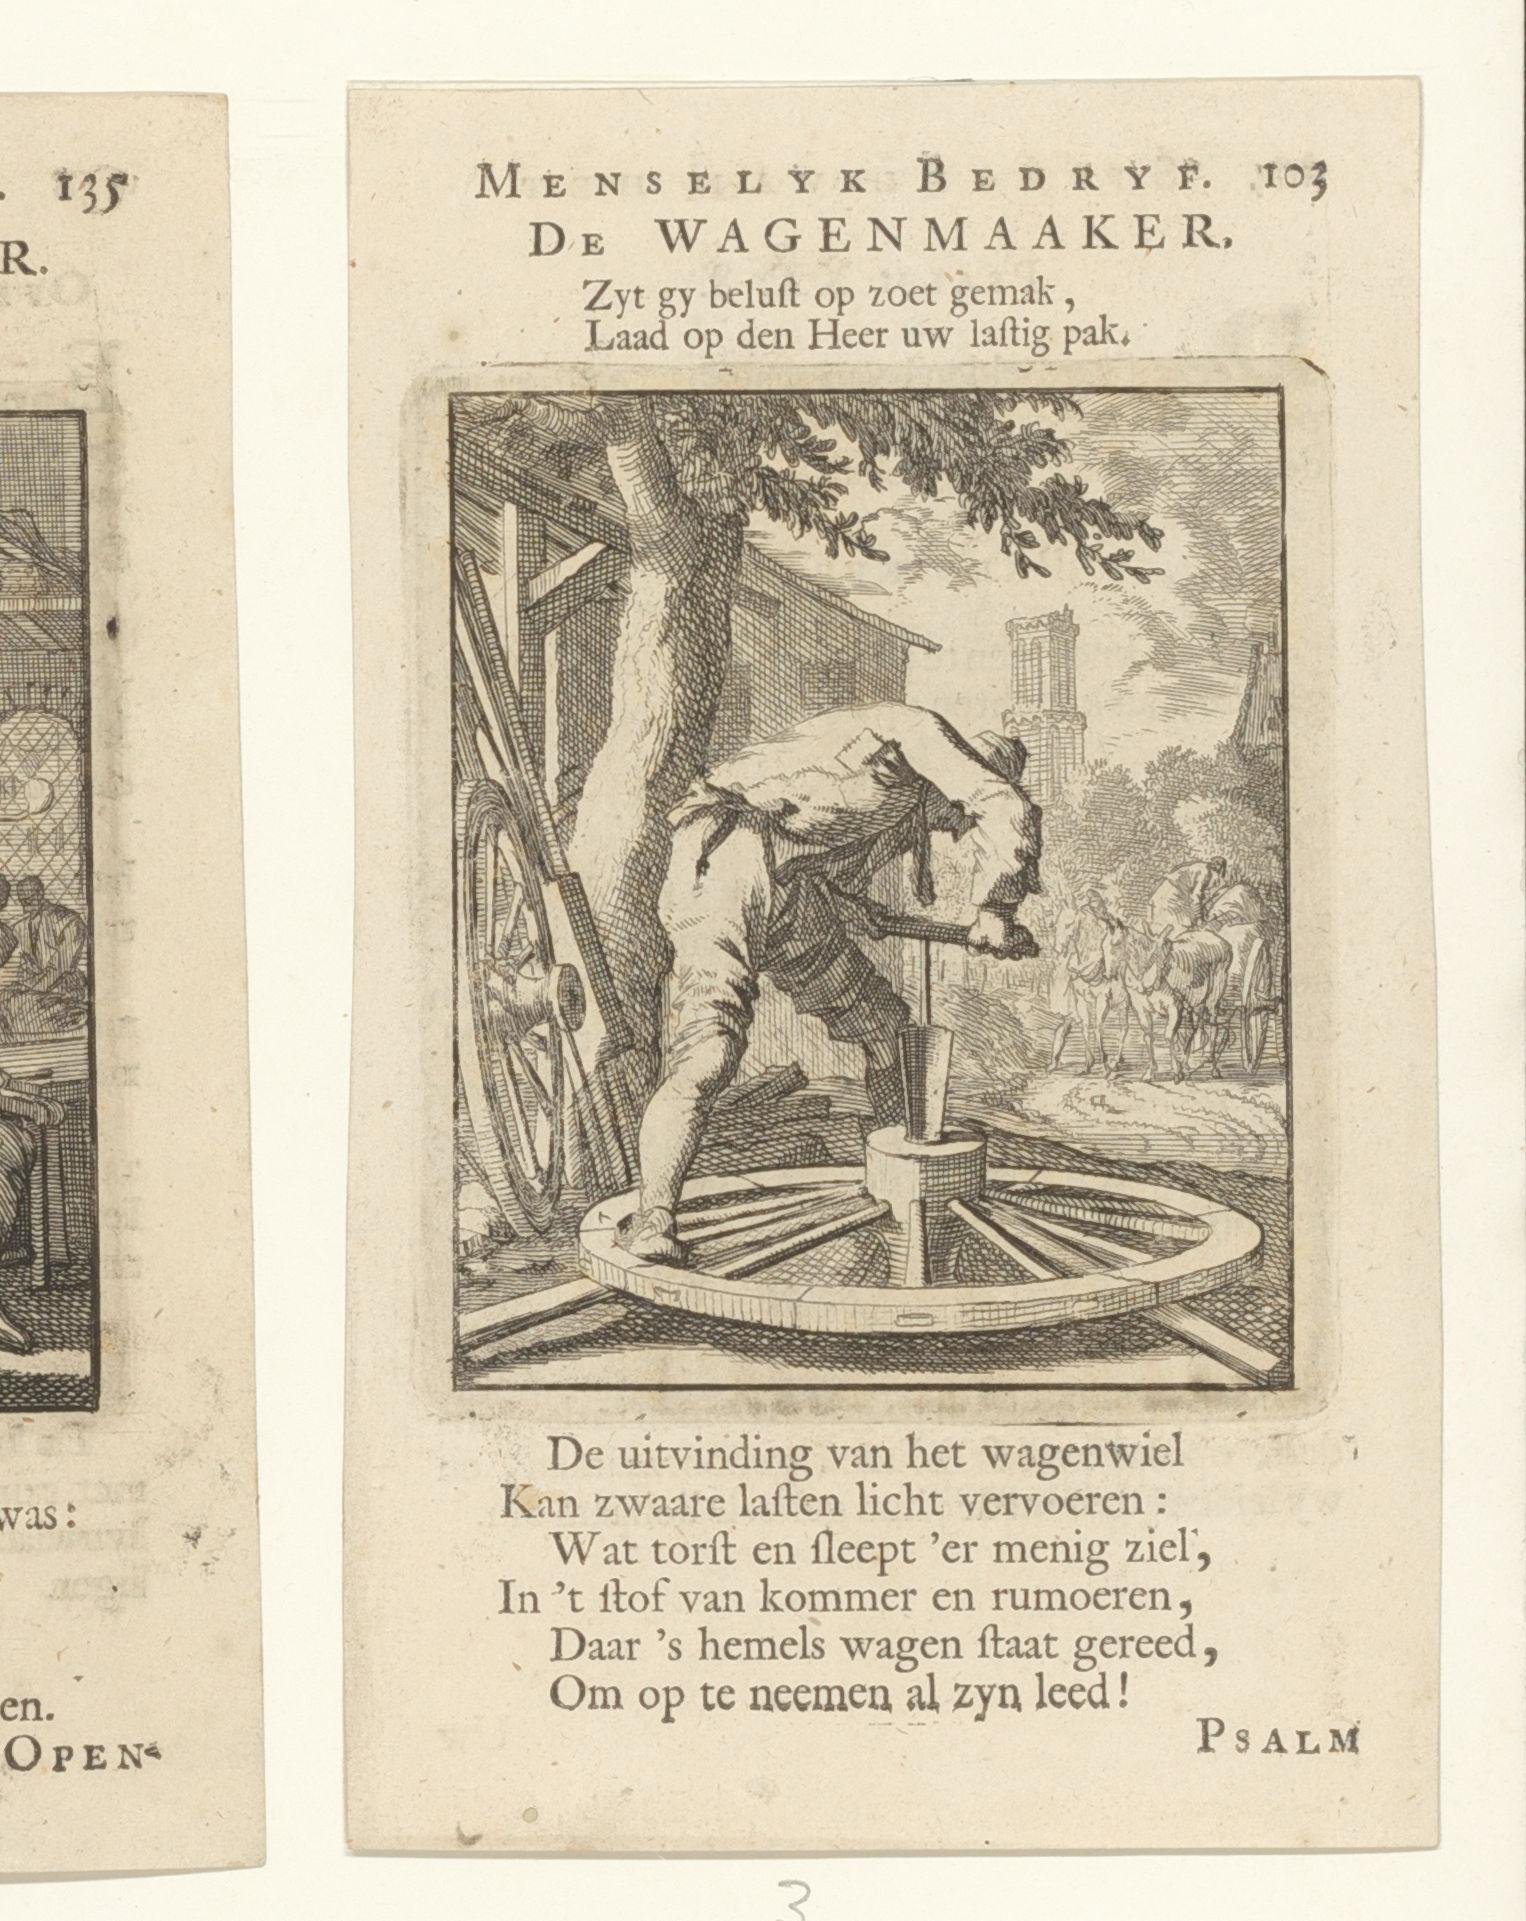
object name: print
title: De Wagenmaaker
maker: cornelis van der sys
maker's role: publisher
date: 1718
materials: paper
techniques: etching, letterpress printing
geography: amsterdam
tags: carpenter, handicrafts, craftsman at work, (farm) wagon, freight wagon, cart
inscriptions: collector's mark: Lugt 1641, stamp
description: Prent oorspronkelijk verschenen in de 100-delige serie beroepsprenten van Jan en Caspar Luyken, getiteld: Het menselyk bedryf. S.l.s.n., 1694 (eerste druk). Daarna is de titel en het vers afgesneden. De prenten in diverse publicaties verschenen en gekopieerd. Huidige staat uit: Luyken, Jan en Caspar. Spiegel van het menselyk bedryf (...). Amsterdam: Cornelis van der Sys, 1718, p. 103. Prent waarschijnlijk ook gebruikt in eerdere (1704) en latere (1730, 1749, 1767) publicaties.